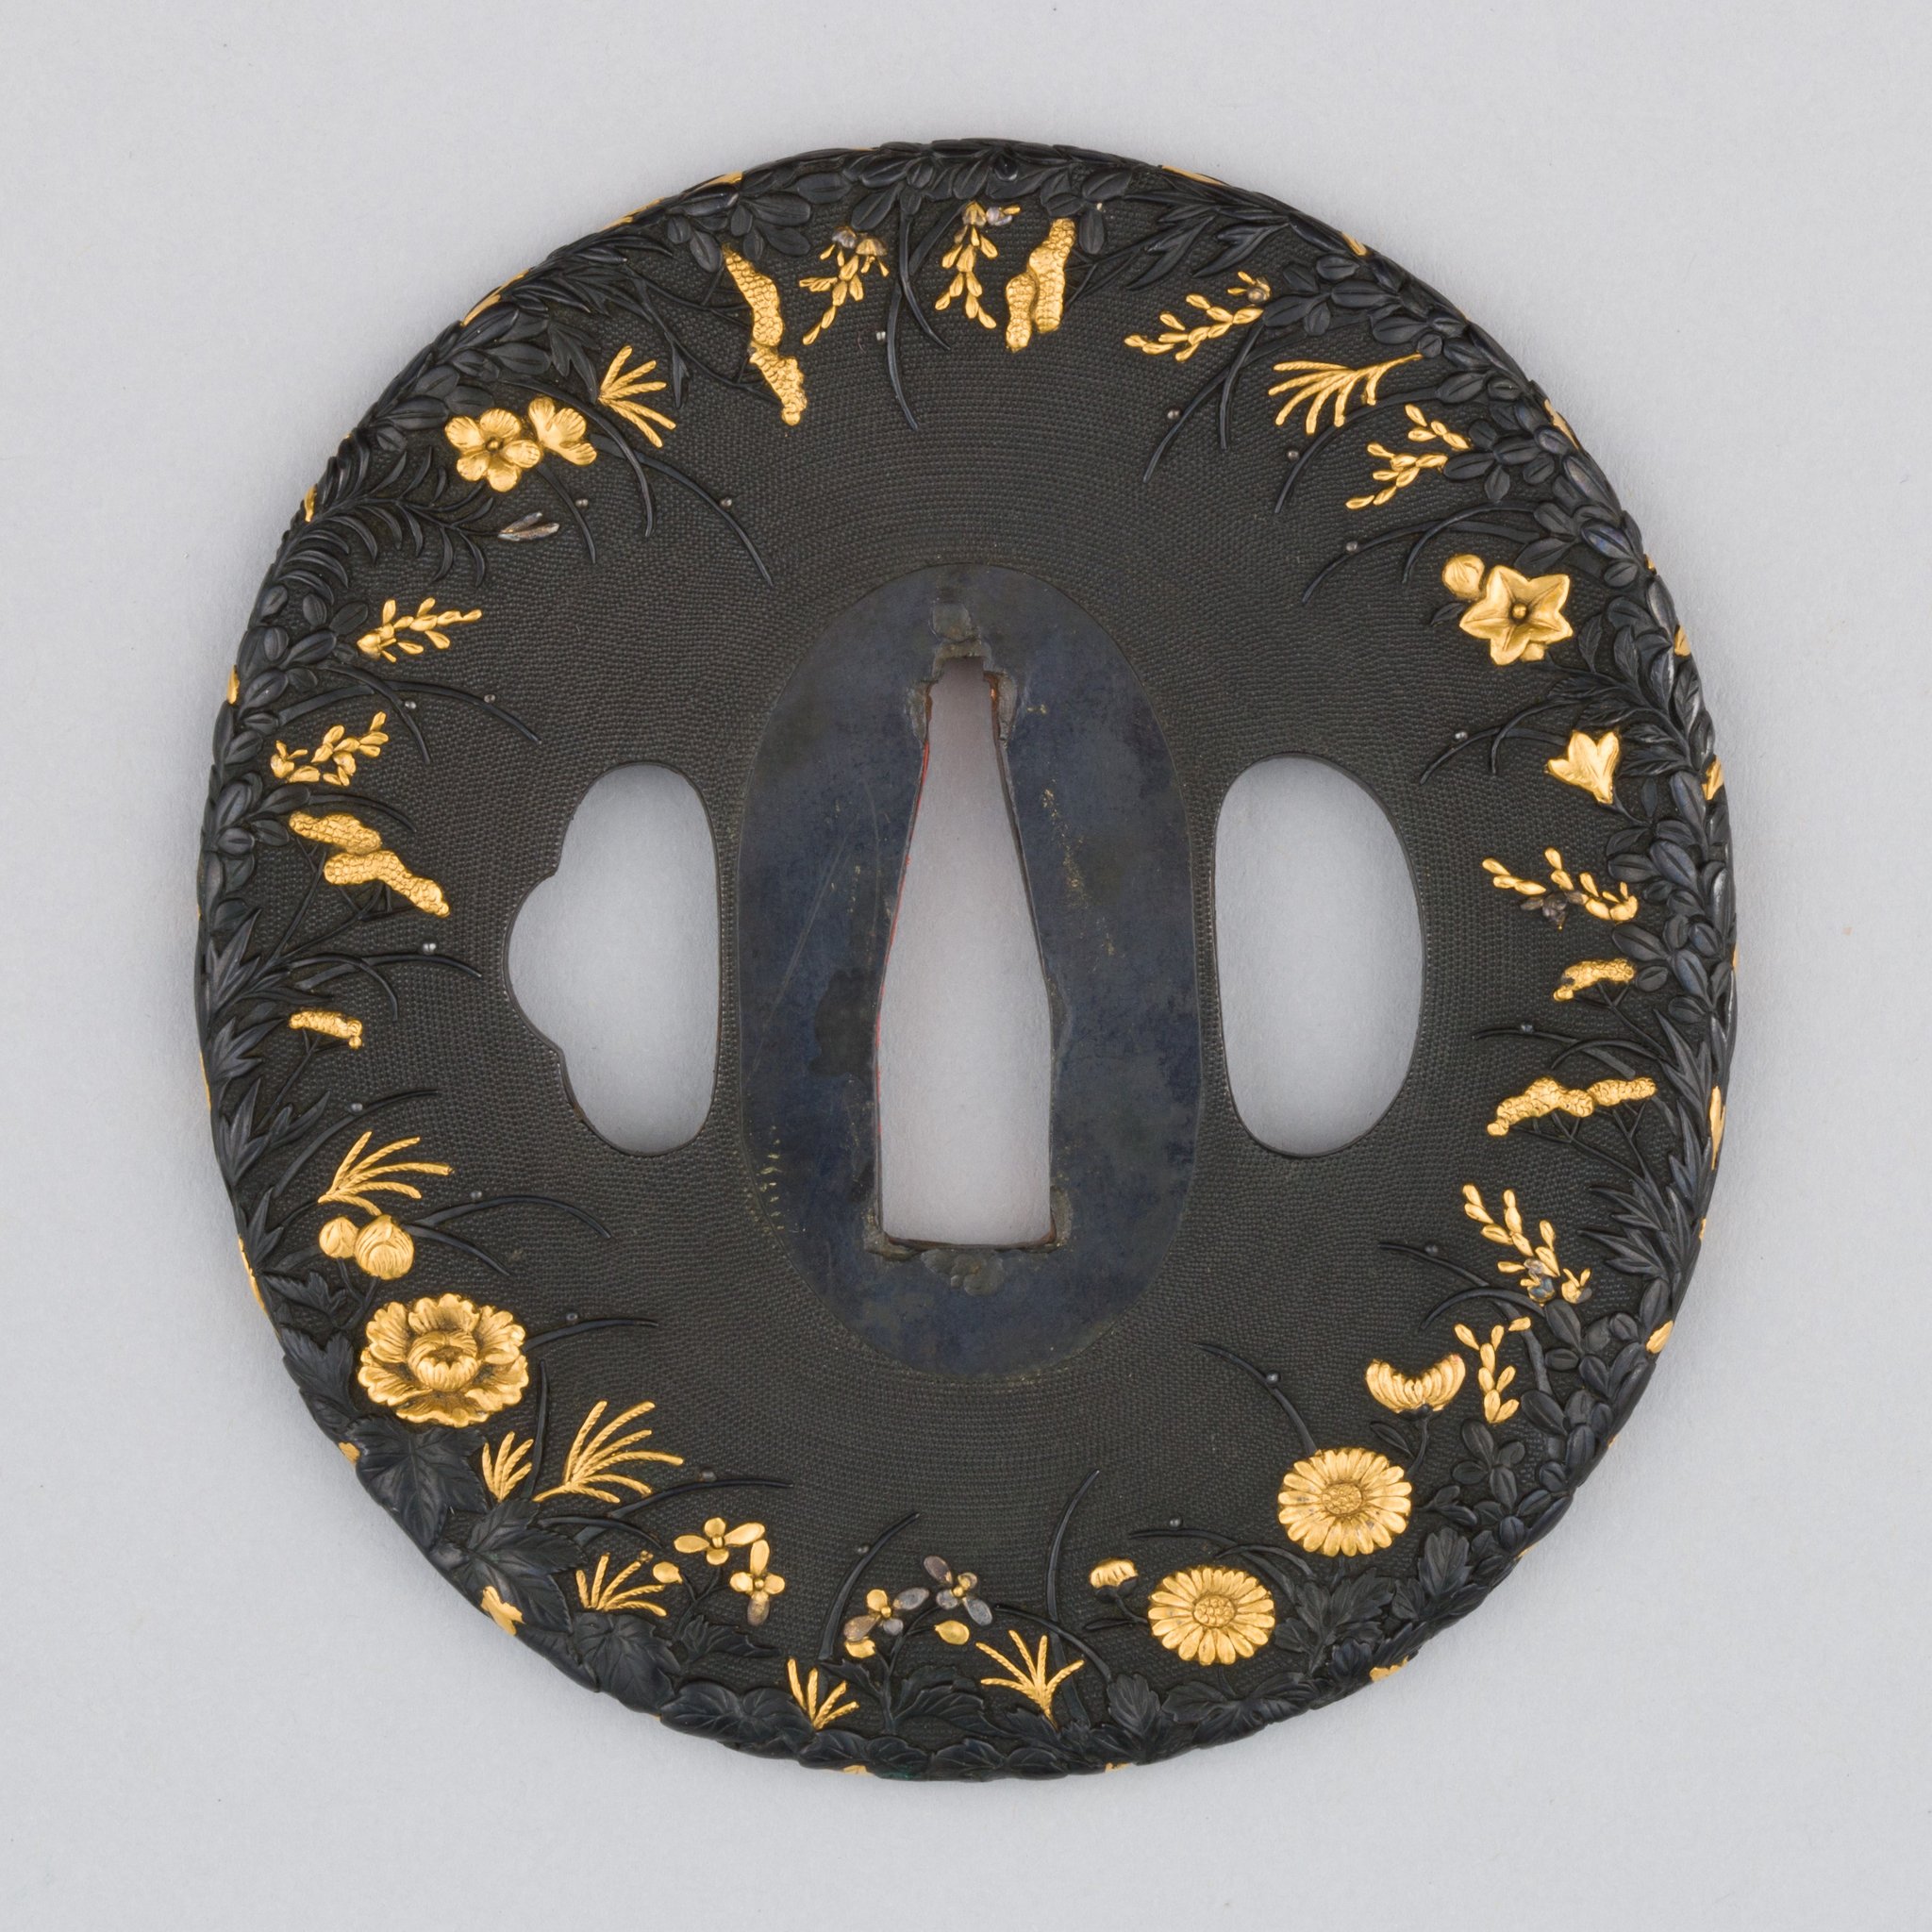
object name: sword guard tsuba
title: Sword Guard (Tsuba)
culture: japanese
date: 1615-1868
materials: copper, gold alloy, gold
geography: japan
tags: flowers